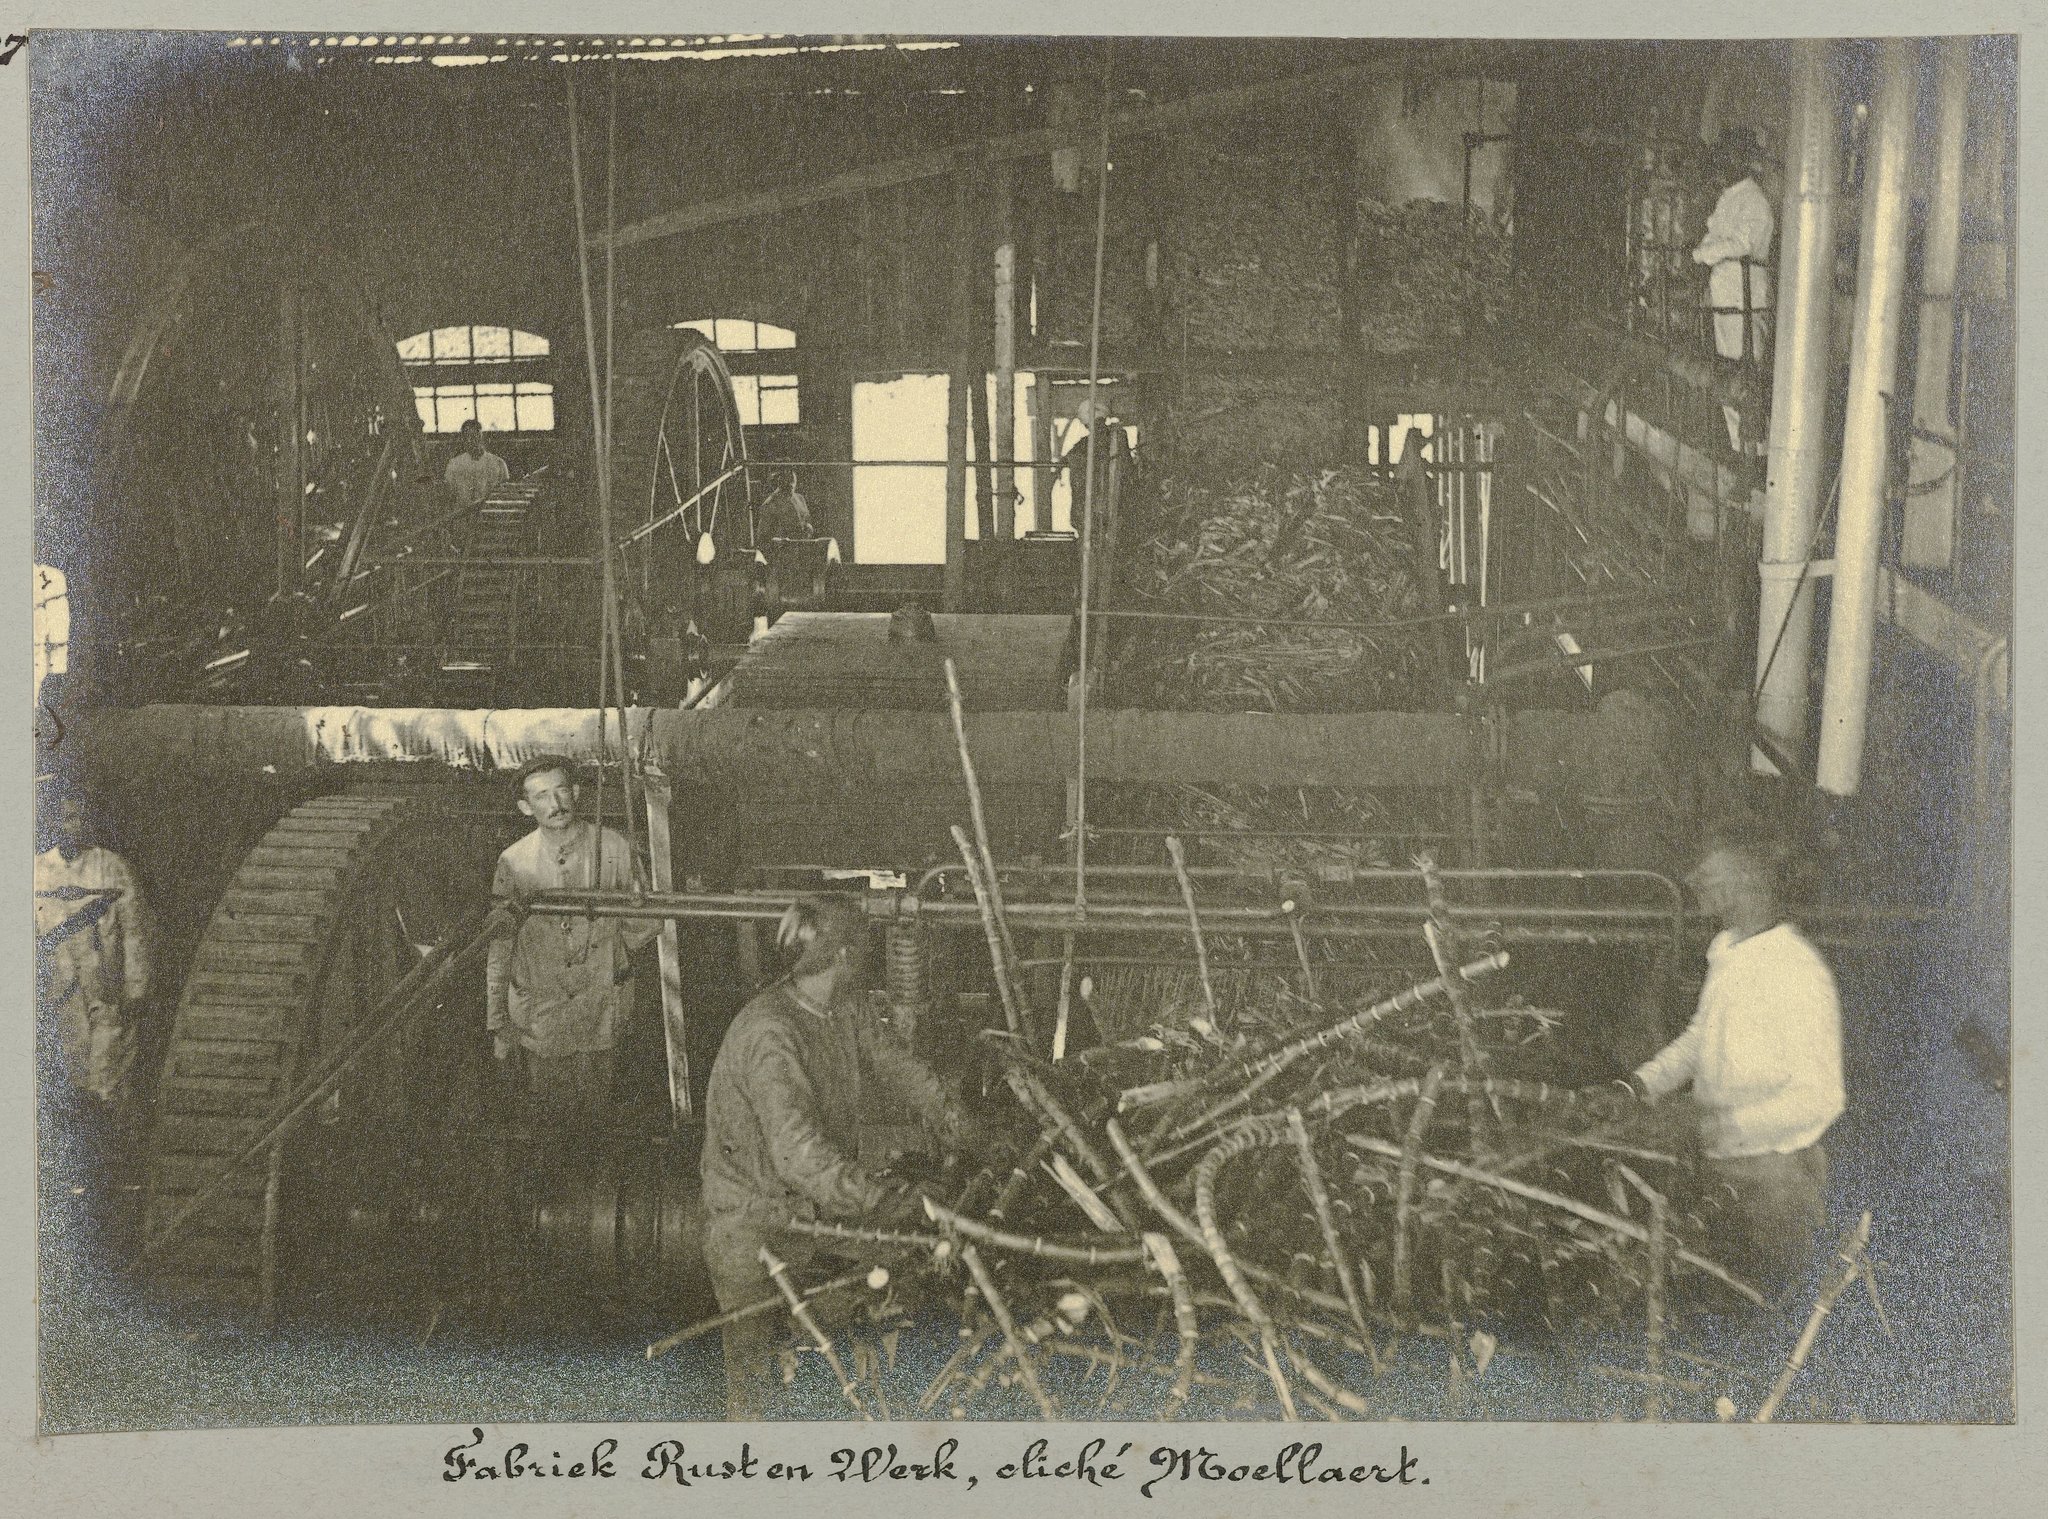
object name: photograph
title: Fabriek Rust en Werk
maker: moellaert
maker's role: fotograaf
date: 1906-1913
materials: photographic support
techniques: gelatin silver print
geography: suriname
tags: suriname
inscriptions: inscription: ‘D7 / Fabriek Rust en Werk, cliché Moellaert.’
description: Interieur van de suikerfabriek op de plantage Rust en Werk. Onderdeel van het fotoalbum Souvenir de Voyage (deel 3), over het leven van de familie Dooyer in en rond de plantage Ma Retraite in Suriname in de jaren 1906-1913.